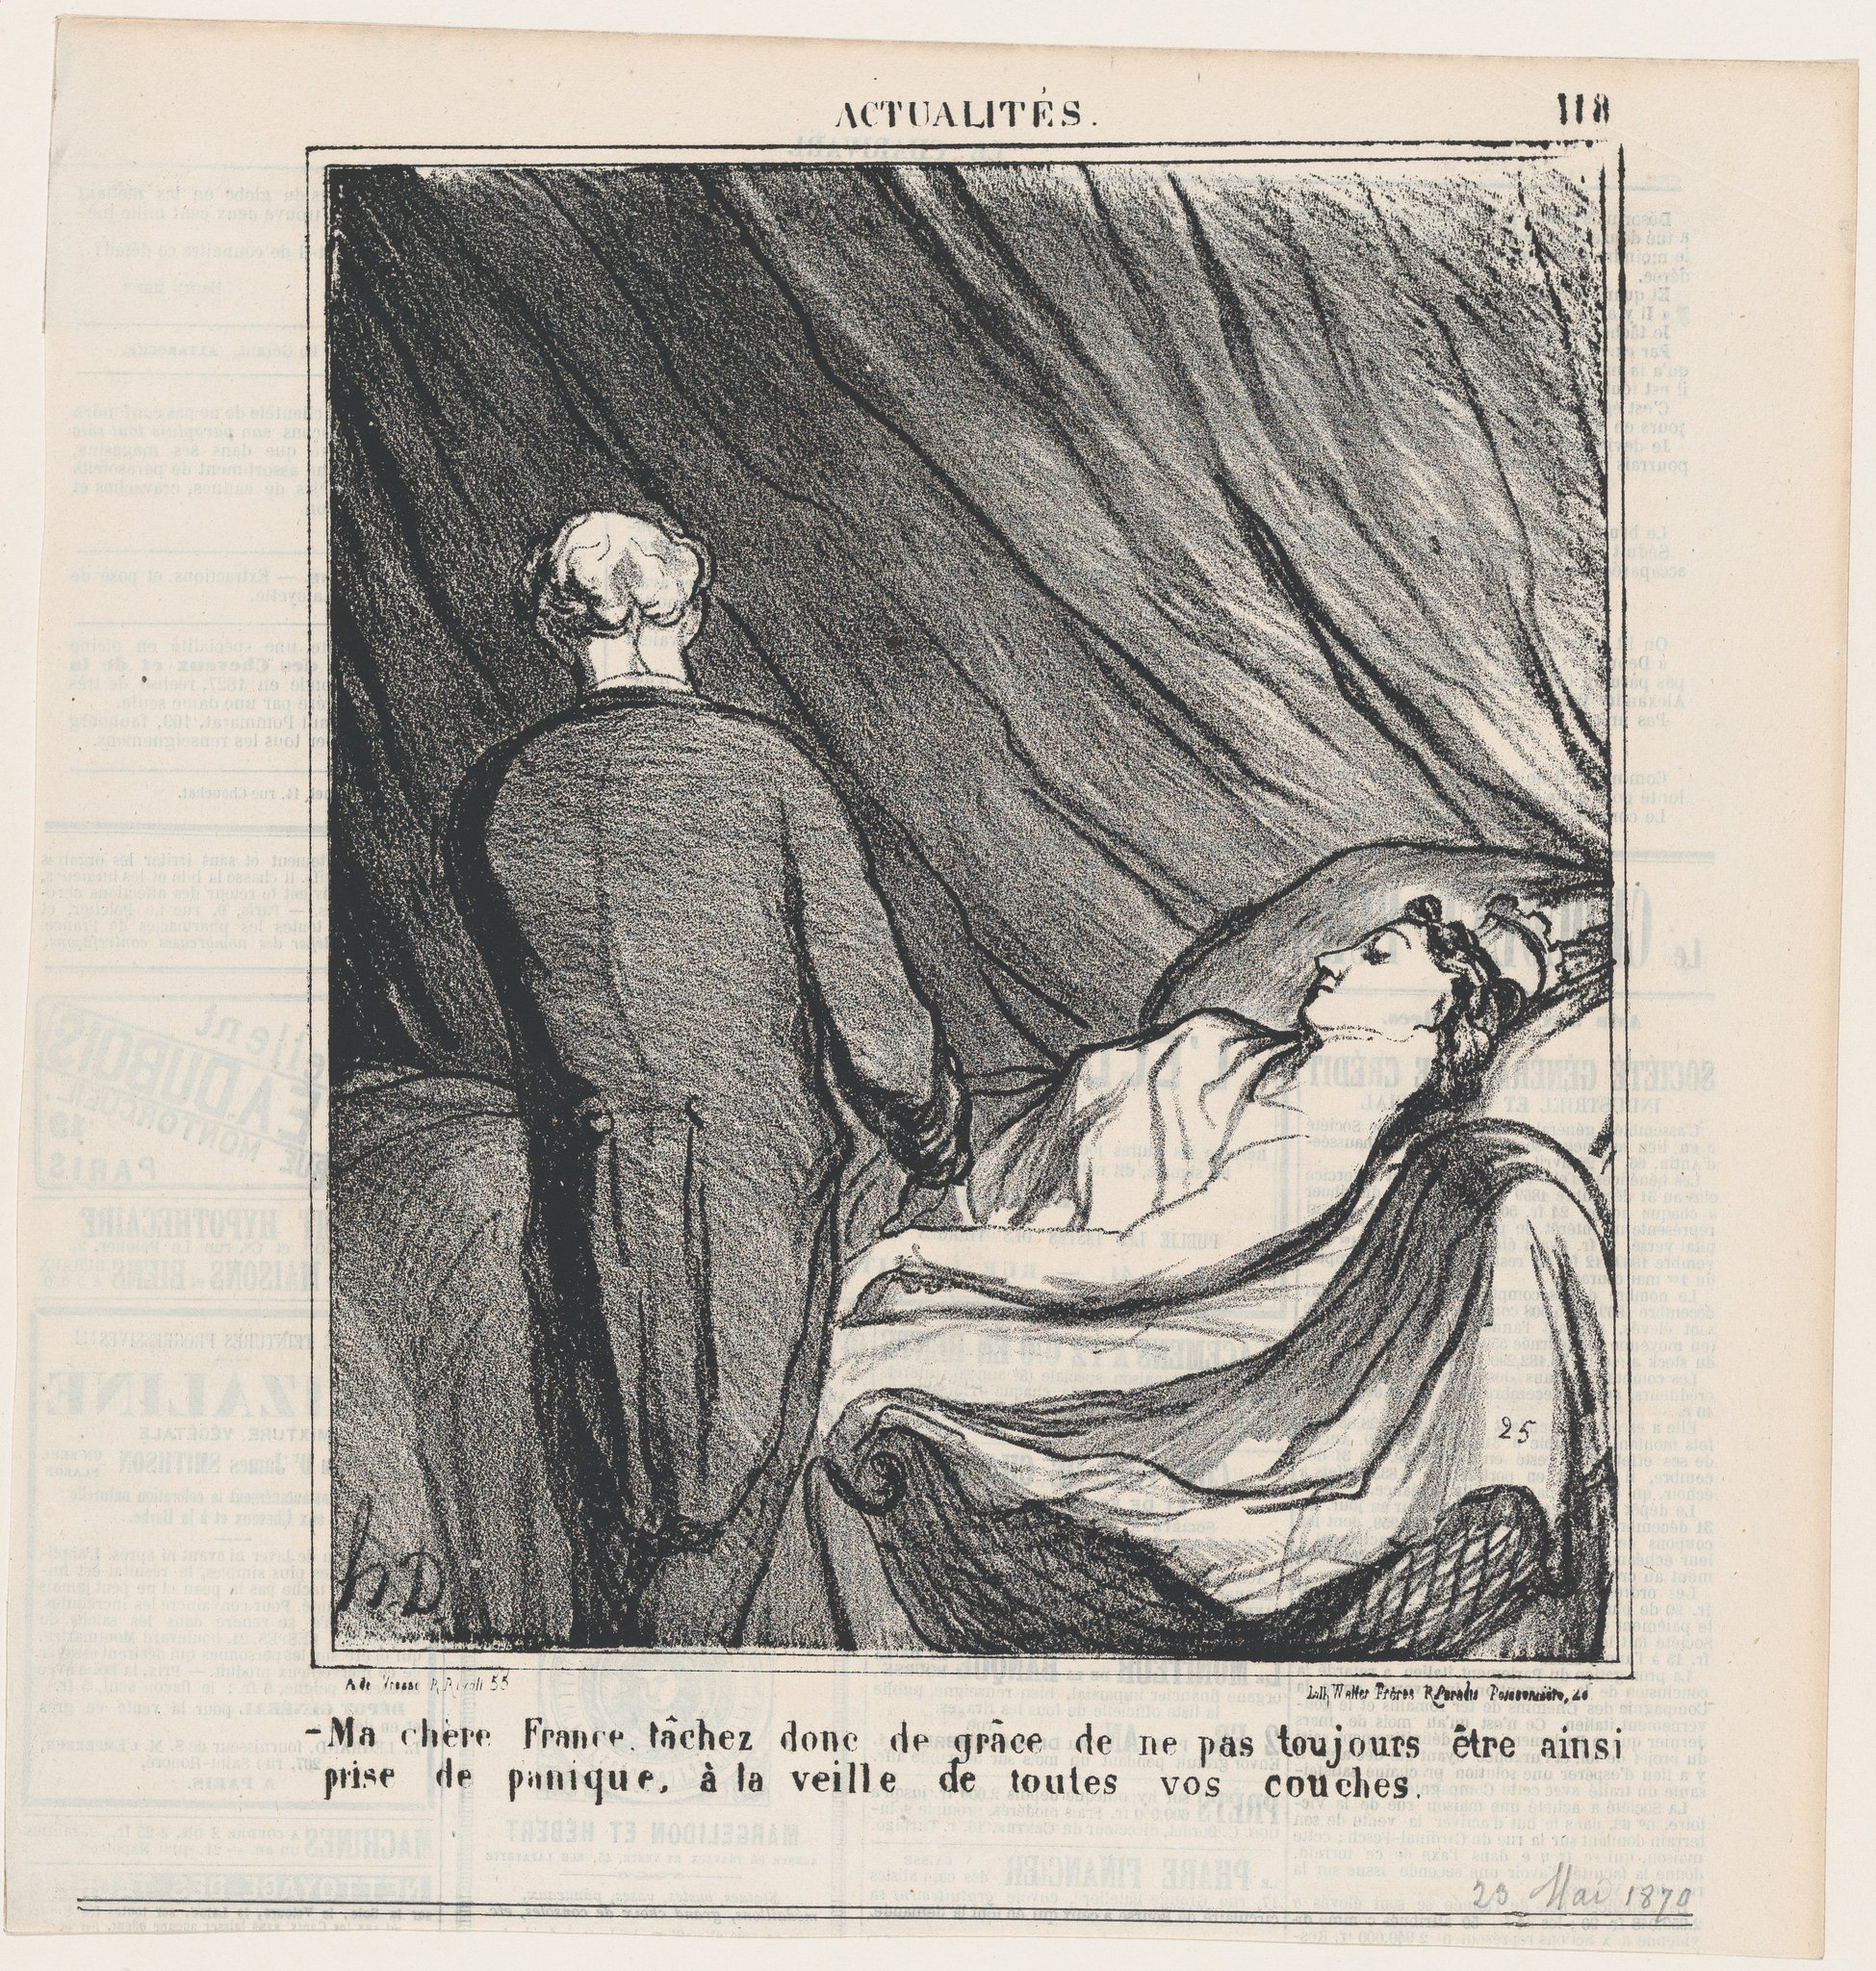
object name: print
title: My dear France, I urge you not to panic every time before your delivery!, from 'News of the day,' published in Le Charivari, March 23, 1870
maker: honoré daumier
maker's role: artist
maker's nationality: french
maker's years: 1808-1879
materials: paper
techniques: lithograph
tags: satire,men,women